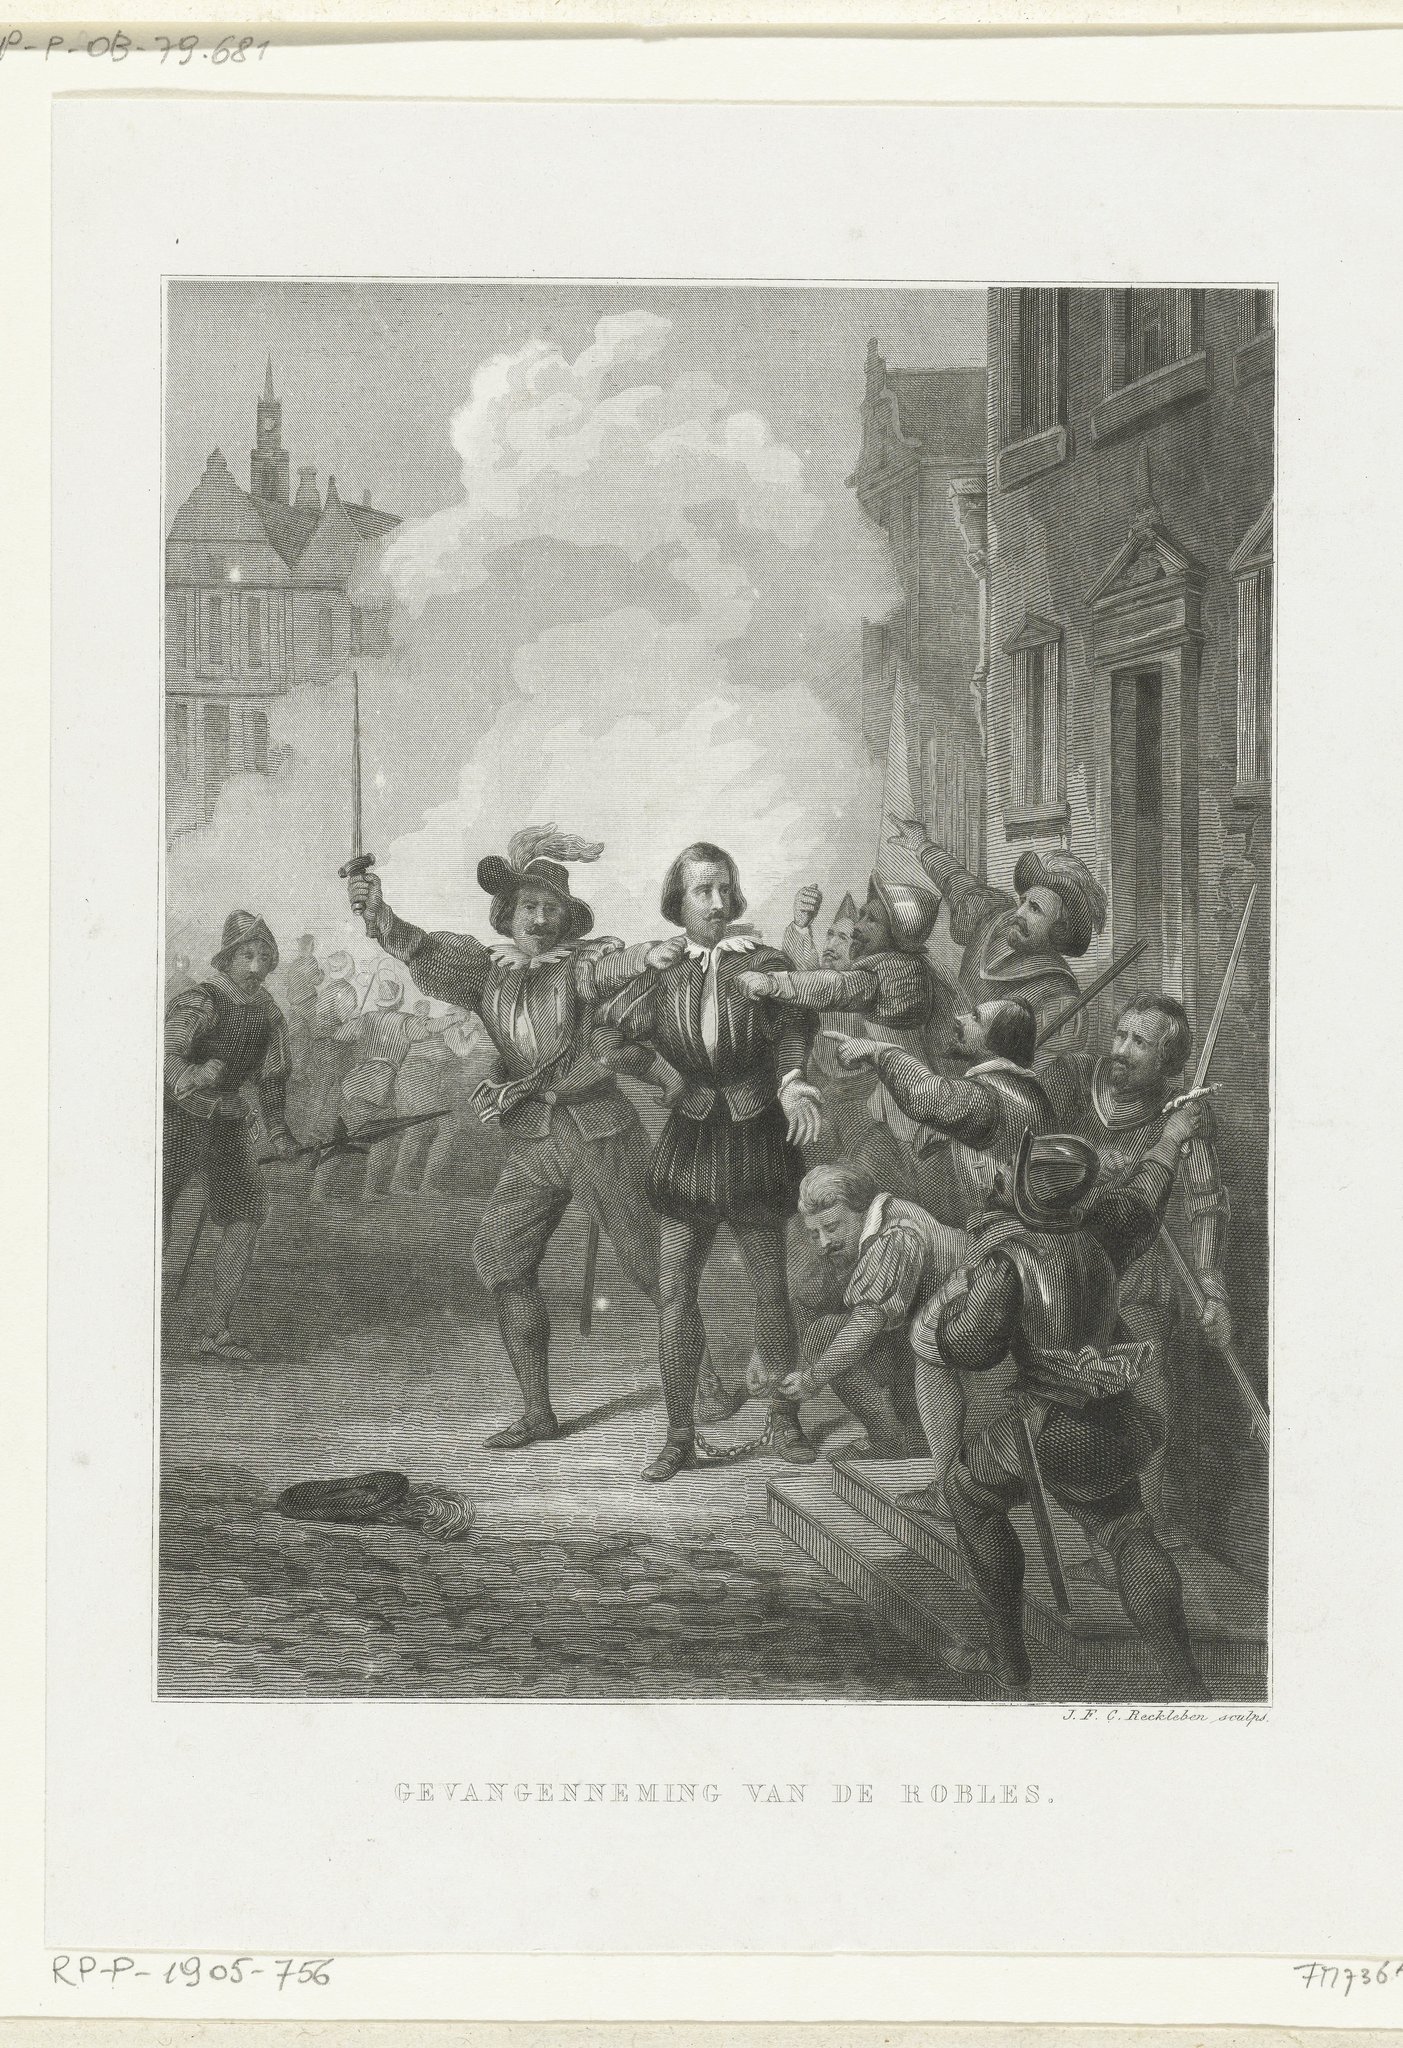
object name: print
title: Gevangenneming van Caspar de Robles, 1576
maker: jan frederik christiaan reckleben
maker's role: print maker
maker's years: 1819-1879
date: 1851-1853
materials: paper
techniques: engraving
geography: netherlands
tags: antwerp, caspar de robles, prisoner; in fetters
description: Gevangenneming van Caspar de Robles in Groningen door zijn eigen Spaanse soldaten uit ontevredenheid over achterstallig soldij, december 1576.